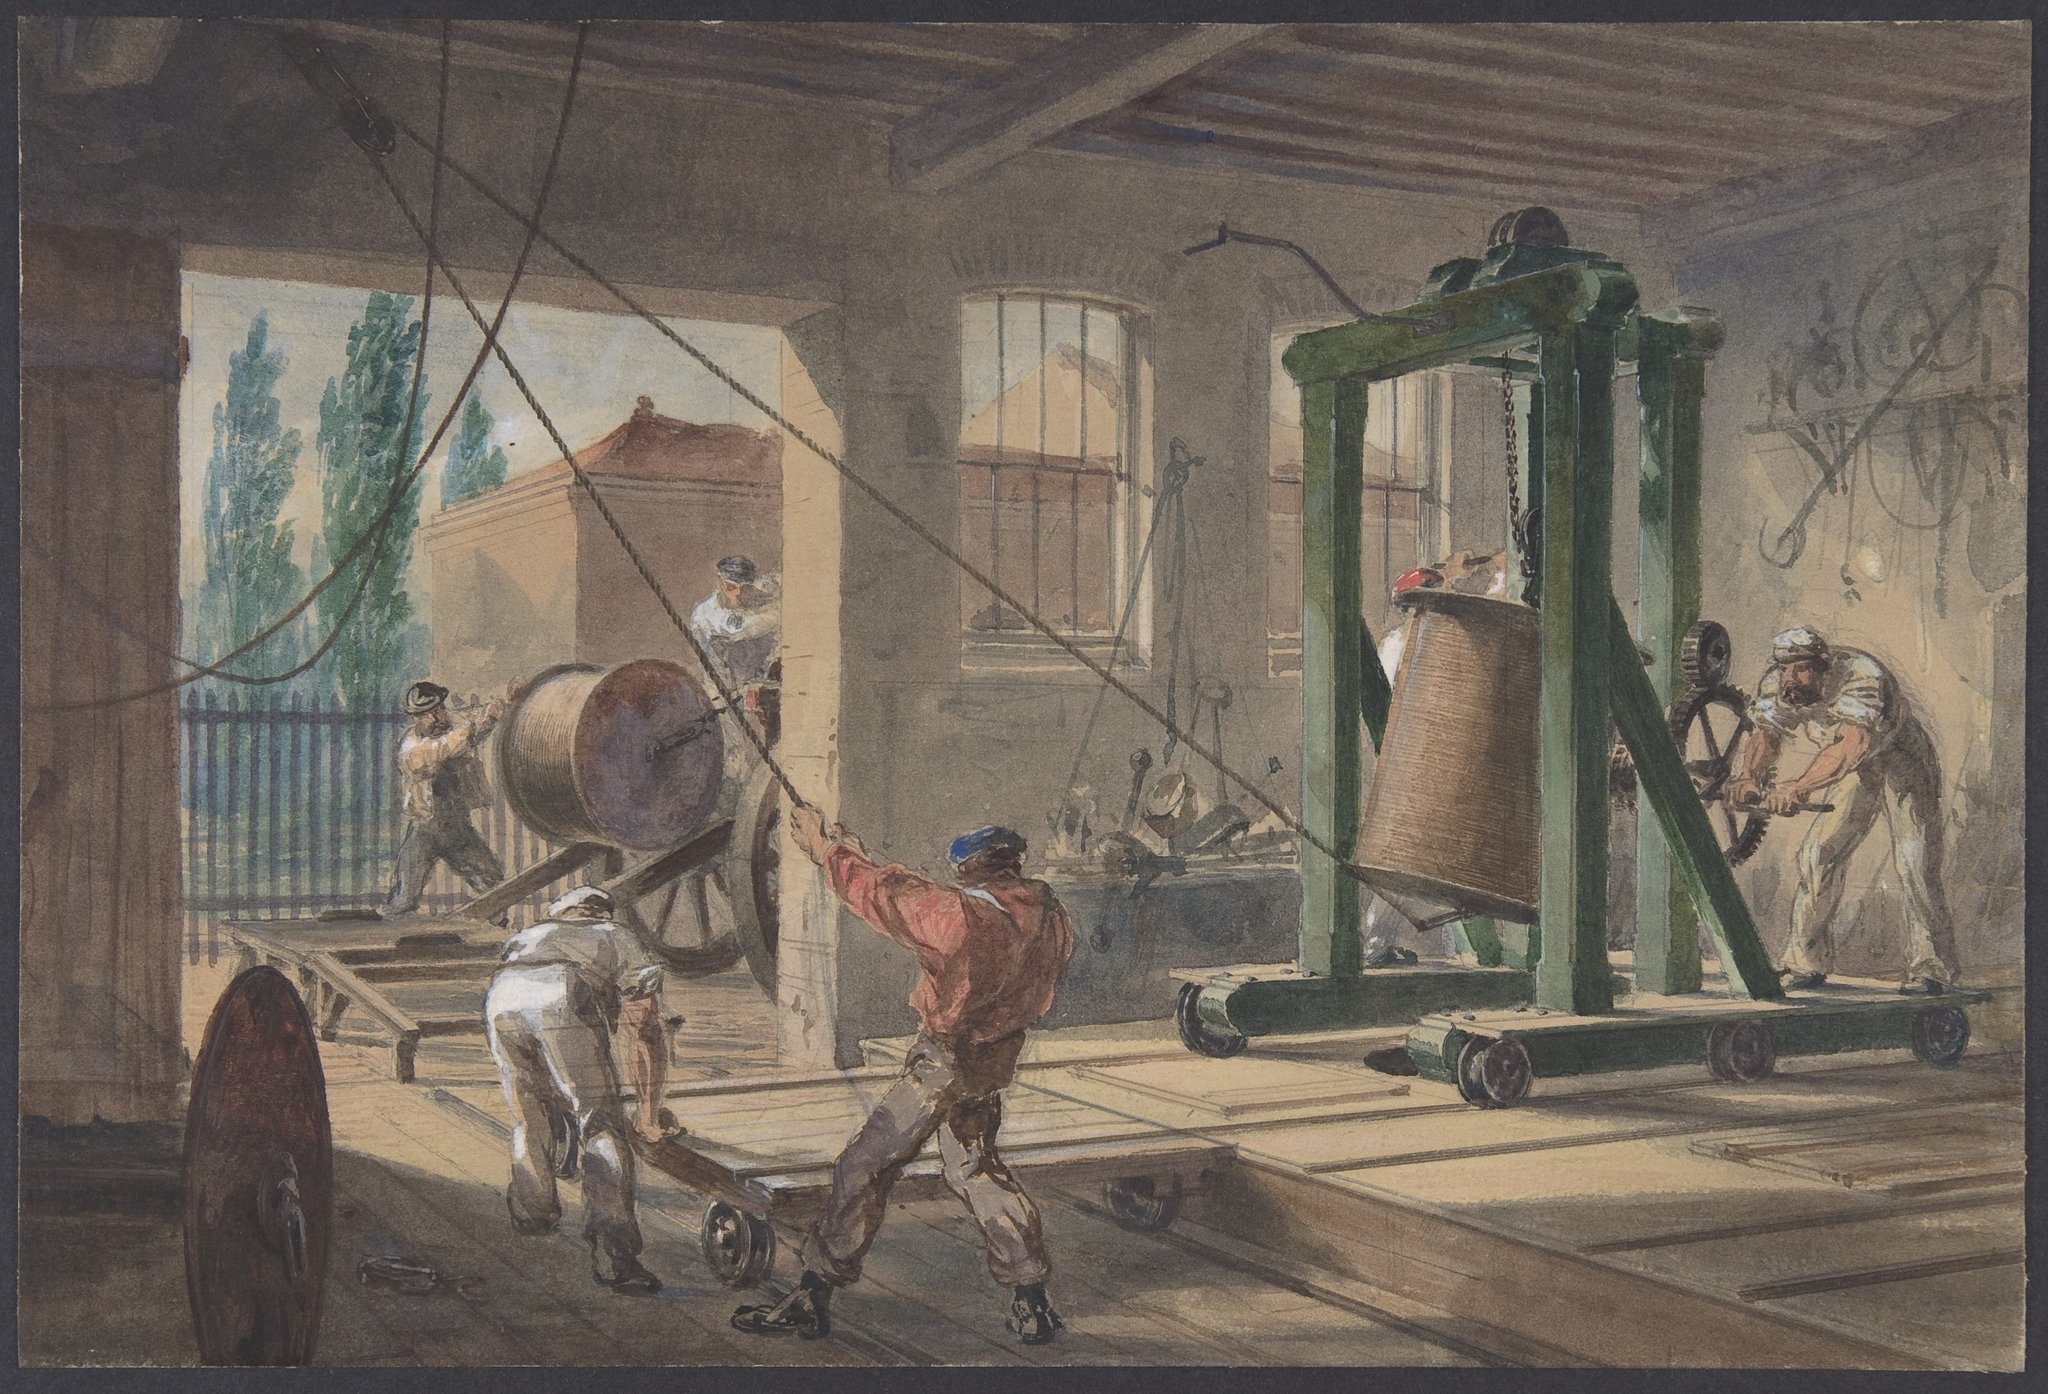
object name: drawing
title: The Reels of Gutta-percha Covered Conducting Wire Conveyed into Tanks at the Works of the Telegraph Construction and Maintenance Company, at Greenwich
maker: robert charles dudley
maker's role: artist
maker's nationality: british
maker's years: 1826-1909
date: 1865-1866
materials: gouache, graphite, watercolor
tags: men,working,machines,transatlantic cable